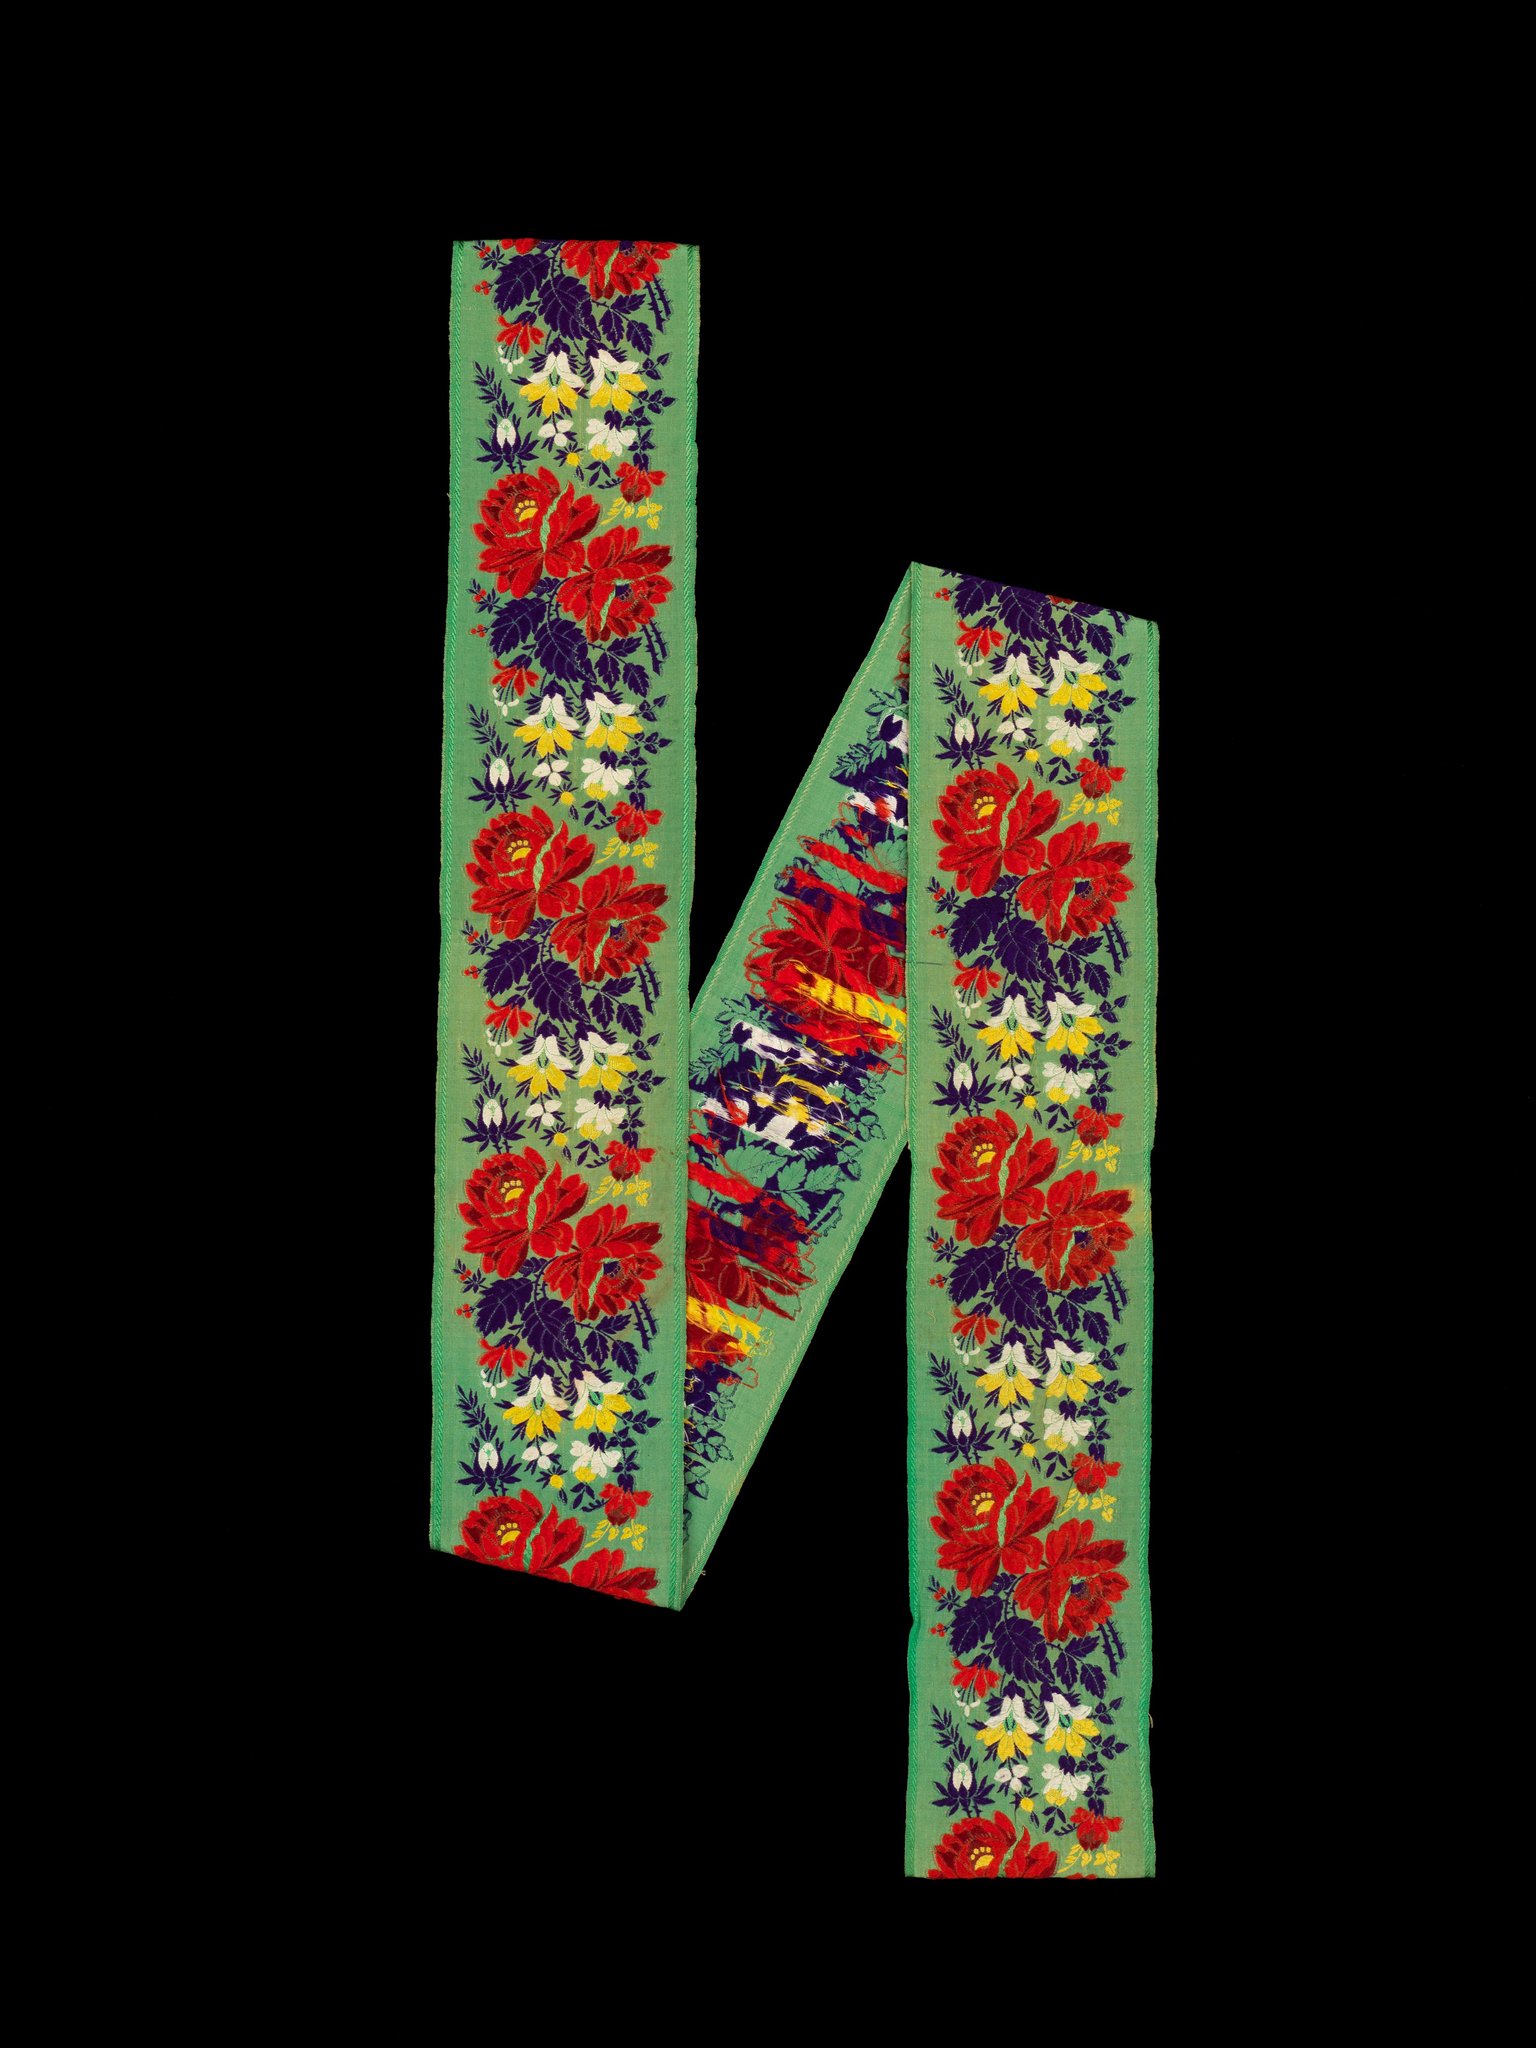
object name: ribbon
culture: european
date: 1860-1899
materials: silk